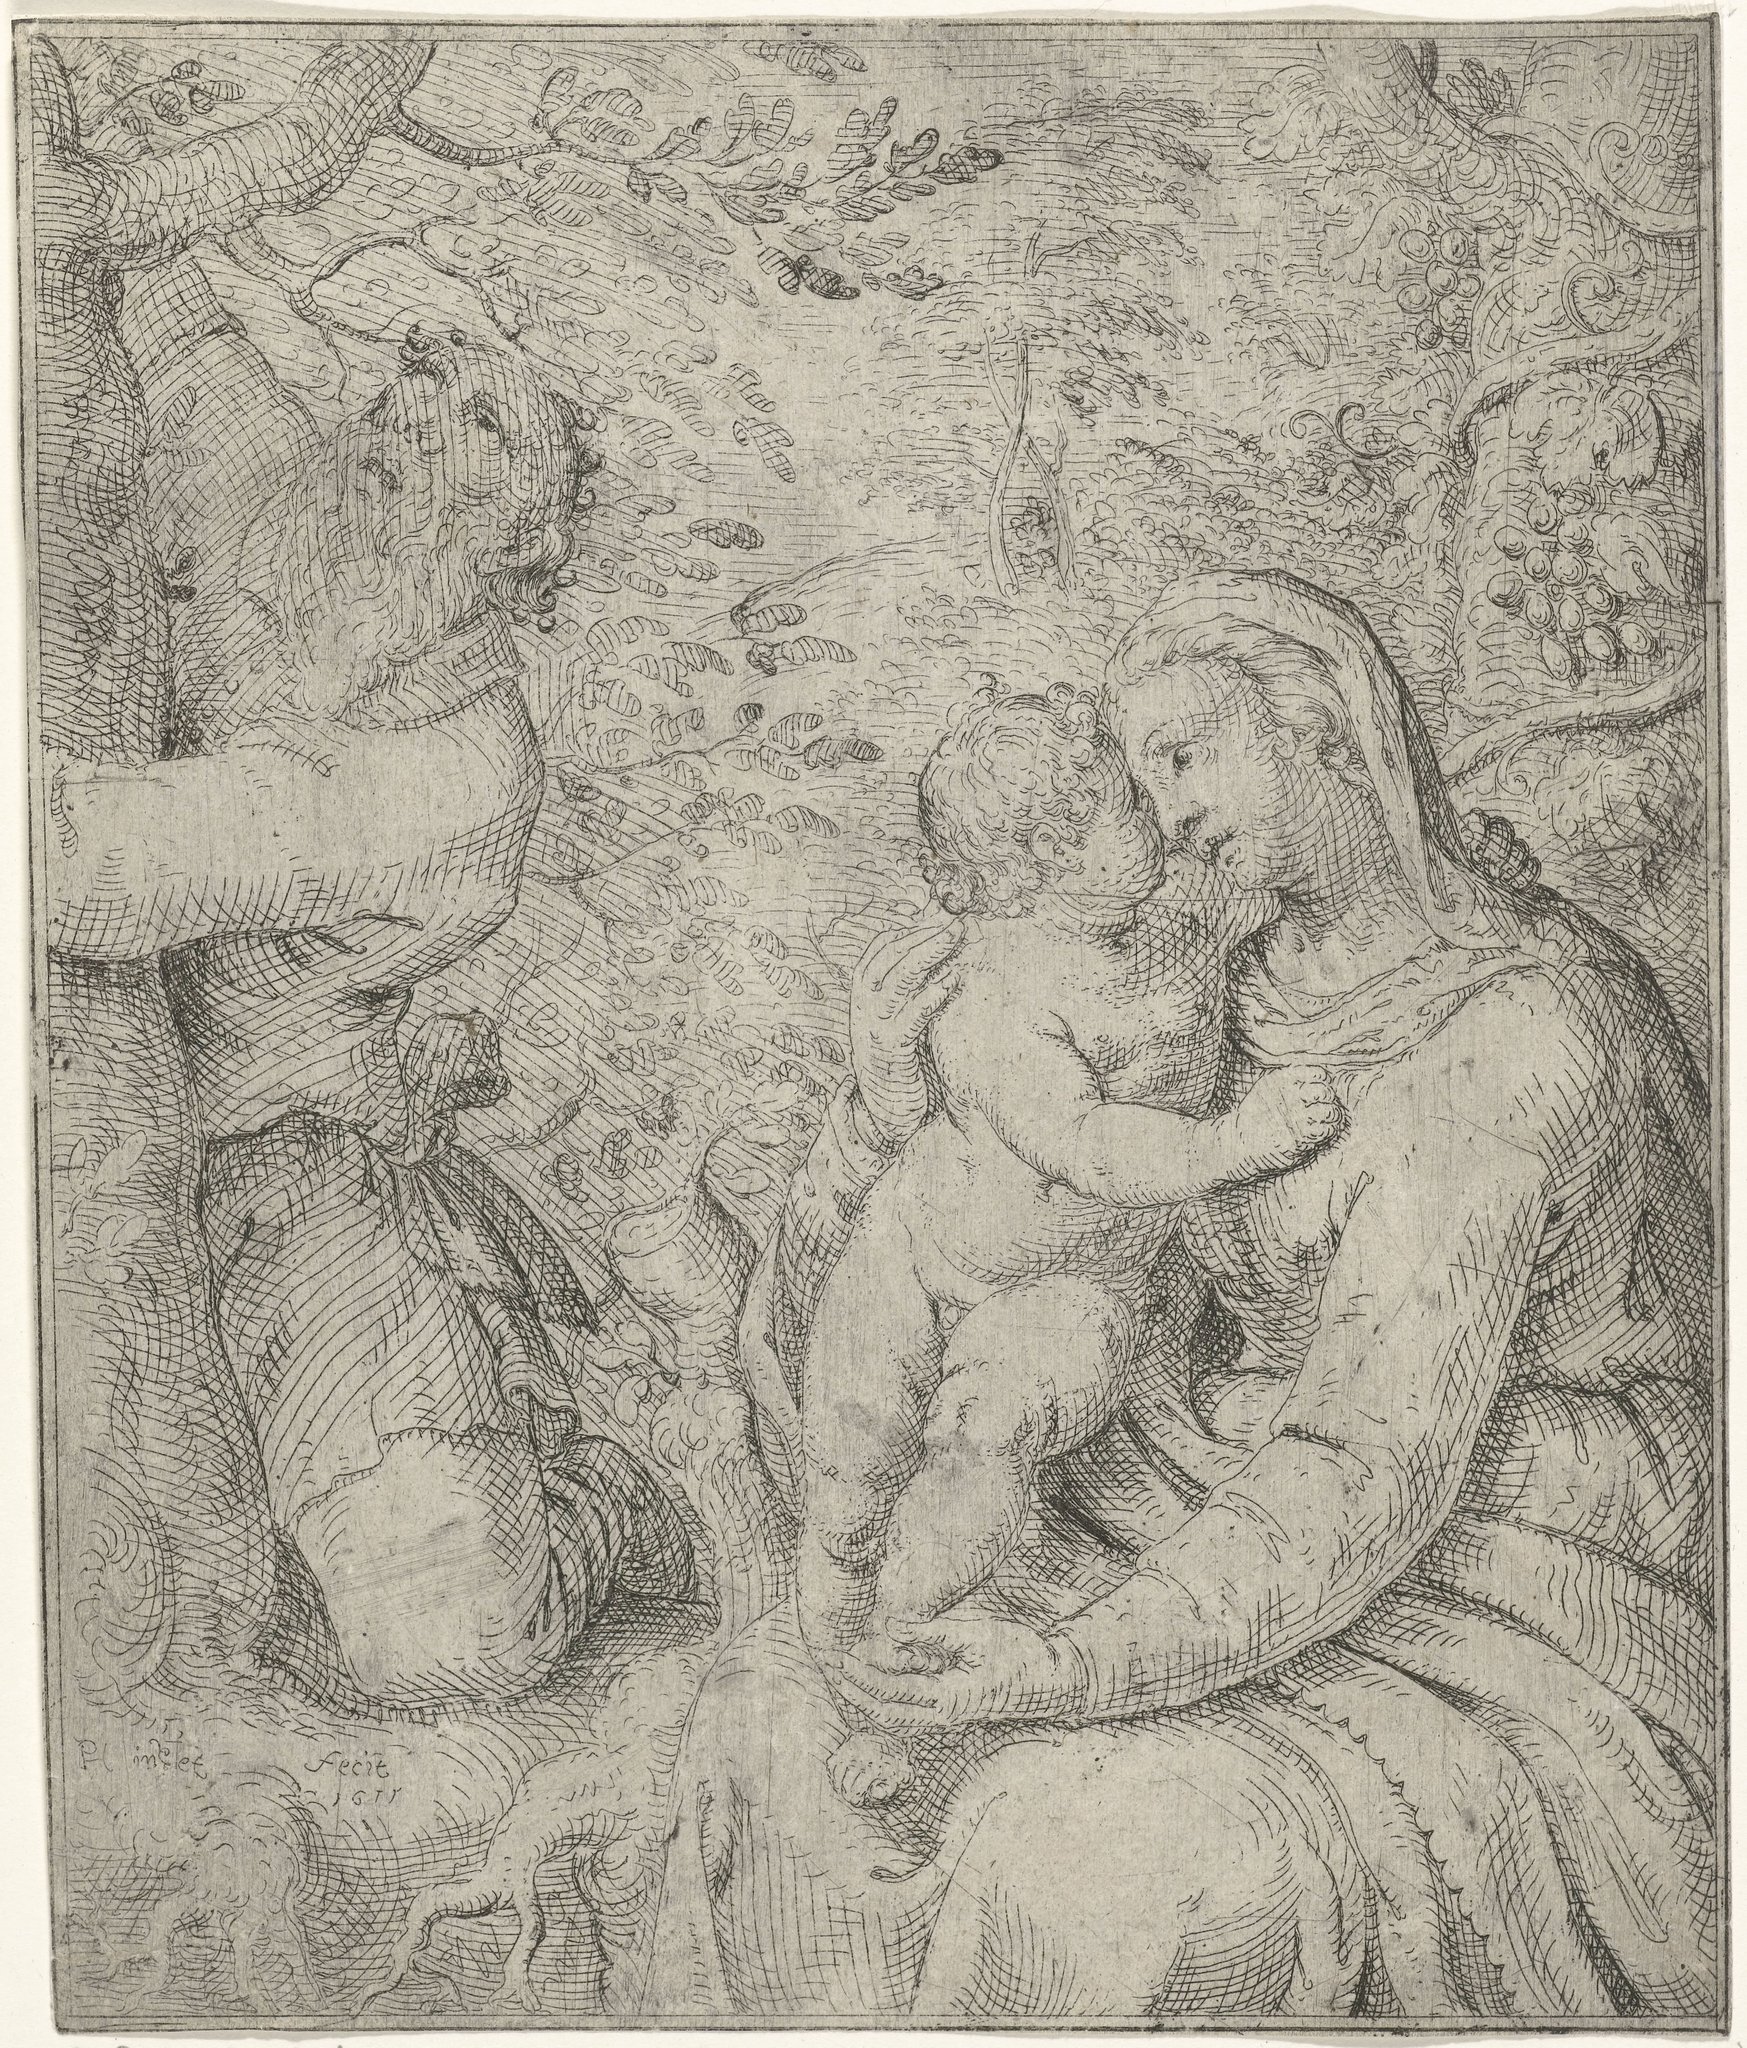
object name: print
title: Rust tijdens de vlucht naar Egypte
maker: pieter feddes van harlingen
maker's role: painter, print maker, publisher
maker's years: 1586-1623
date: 1615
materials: paper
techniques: etching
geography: friesland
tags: rest on the flight into egypt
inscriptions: collector's mark: Lugt 2228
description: Maria zit met het Christuskind op schoot, tegen een boom met druivenranken. Jozef plukt een vrucht uit een boom.